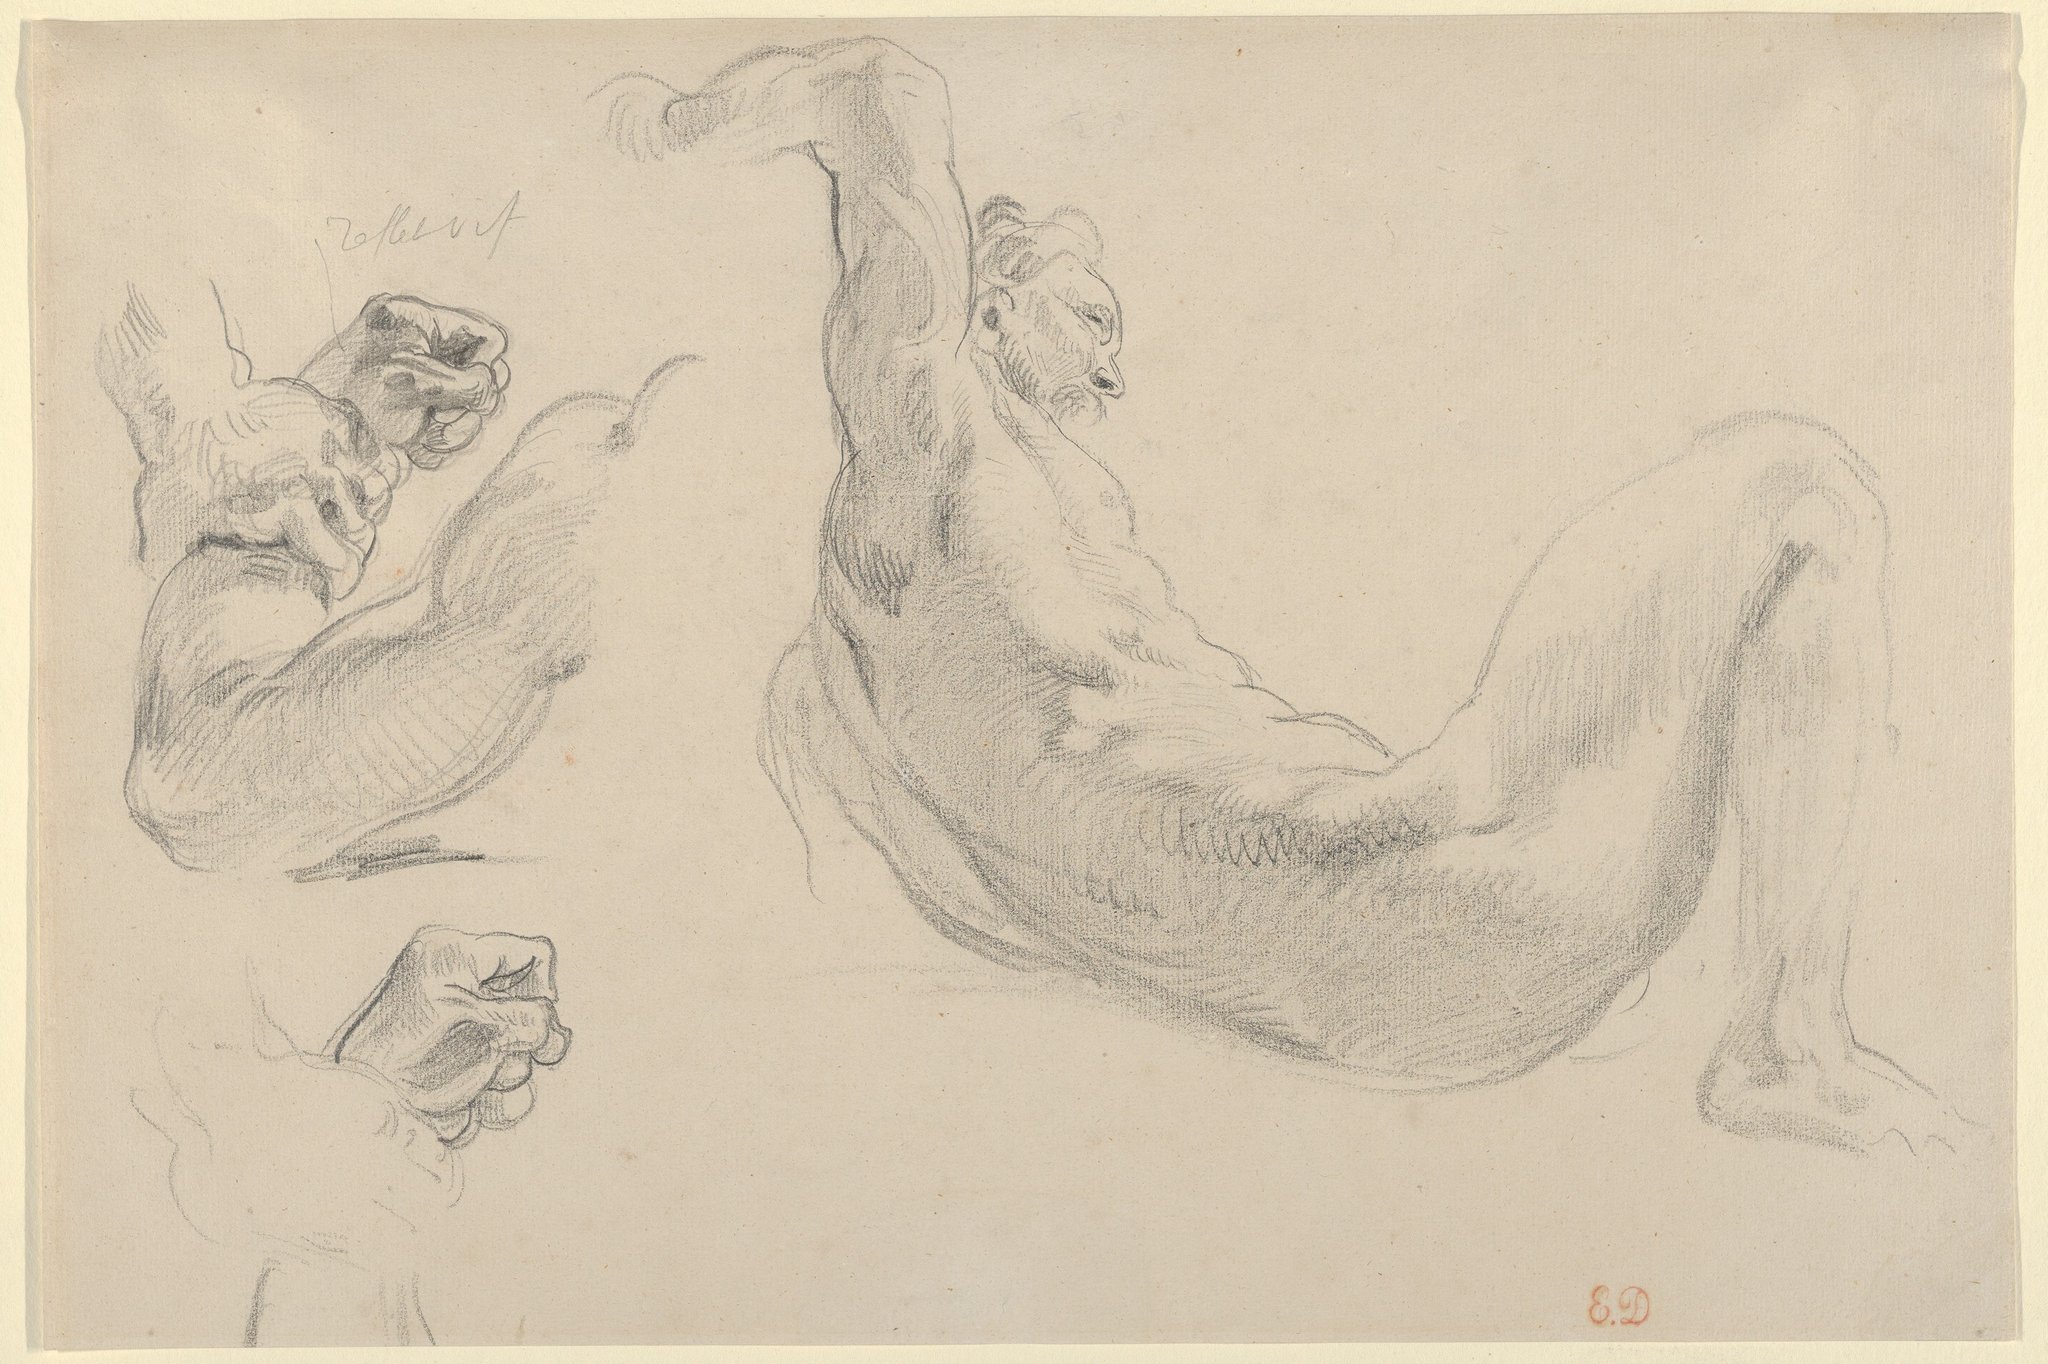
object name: drawing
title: Studies of a Fallen Male Nude for "Hercules and the Horses of Diomedes"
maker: eugène delacroix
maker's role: artist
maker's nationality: french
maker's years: 1798-1863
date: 1852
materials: graphite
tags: hands,male nudes,hercules